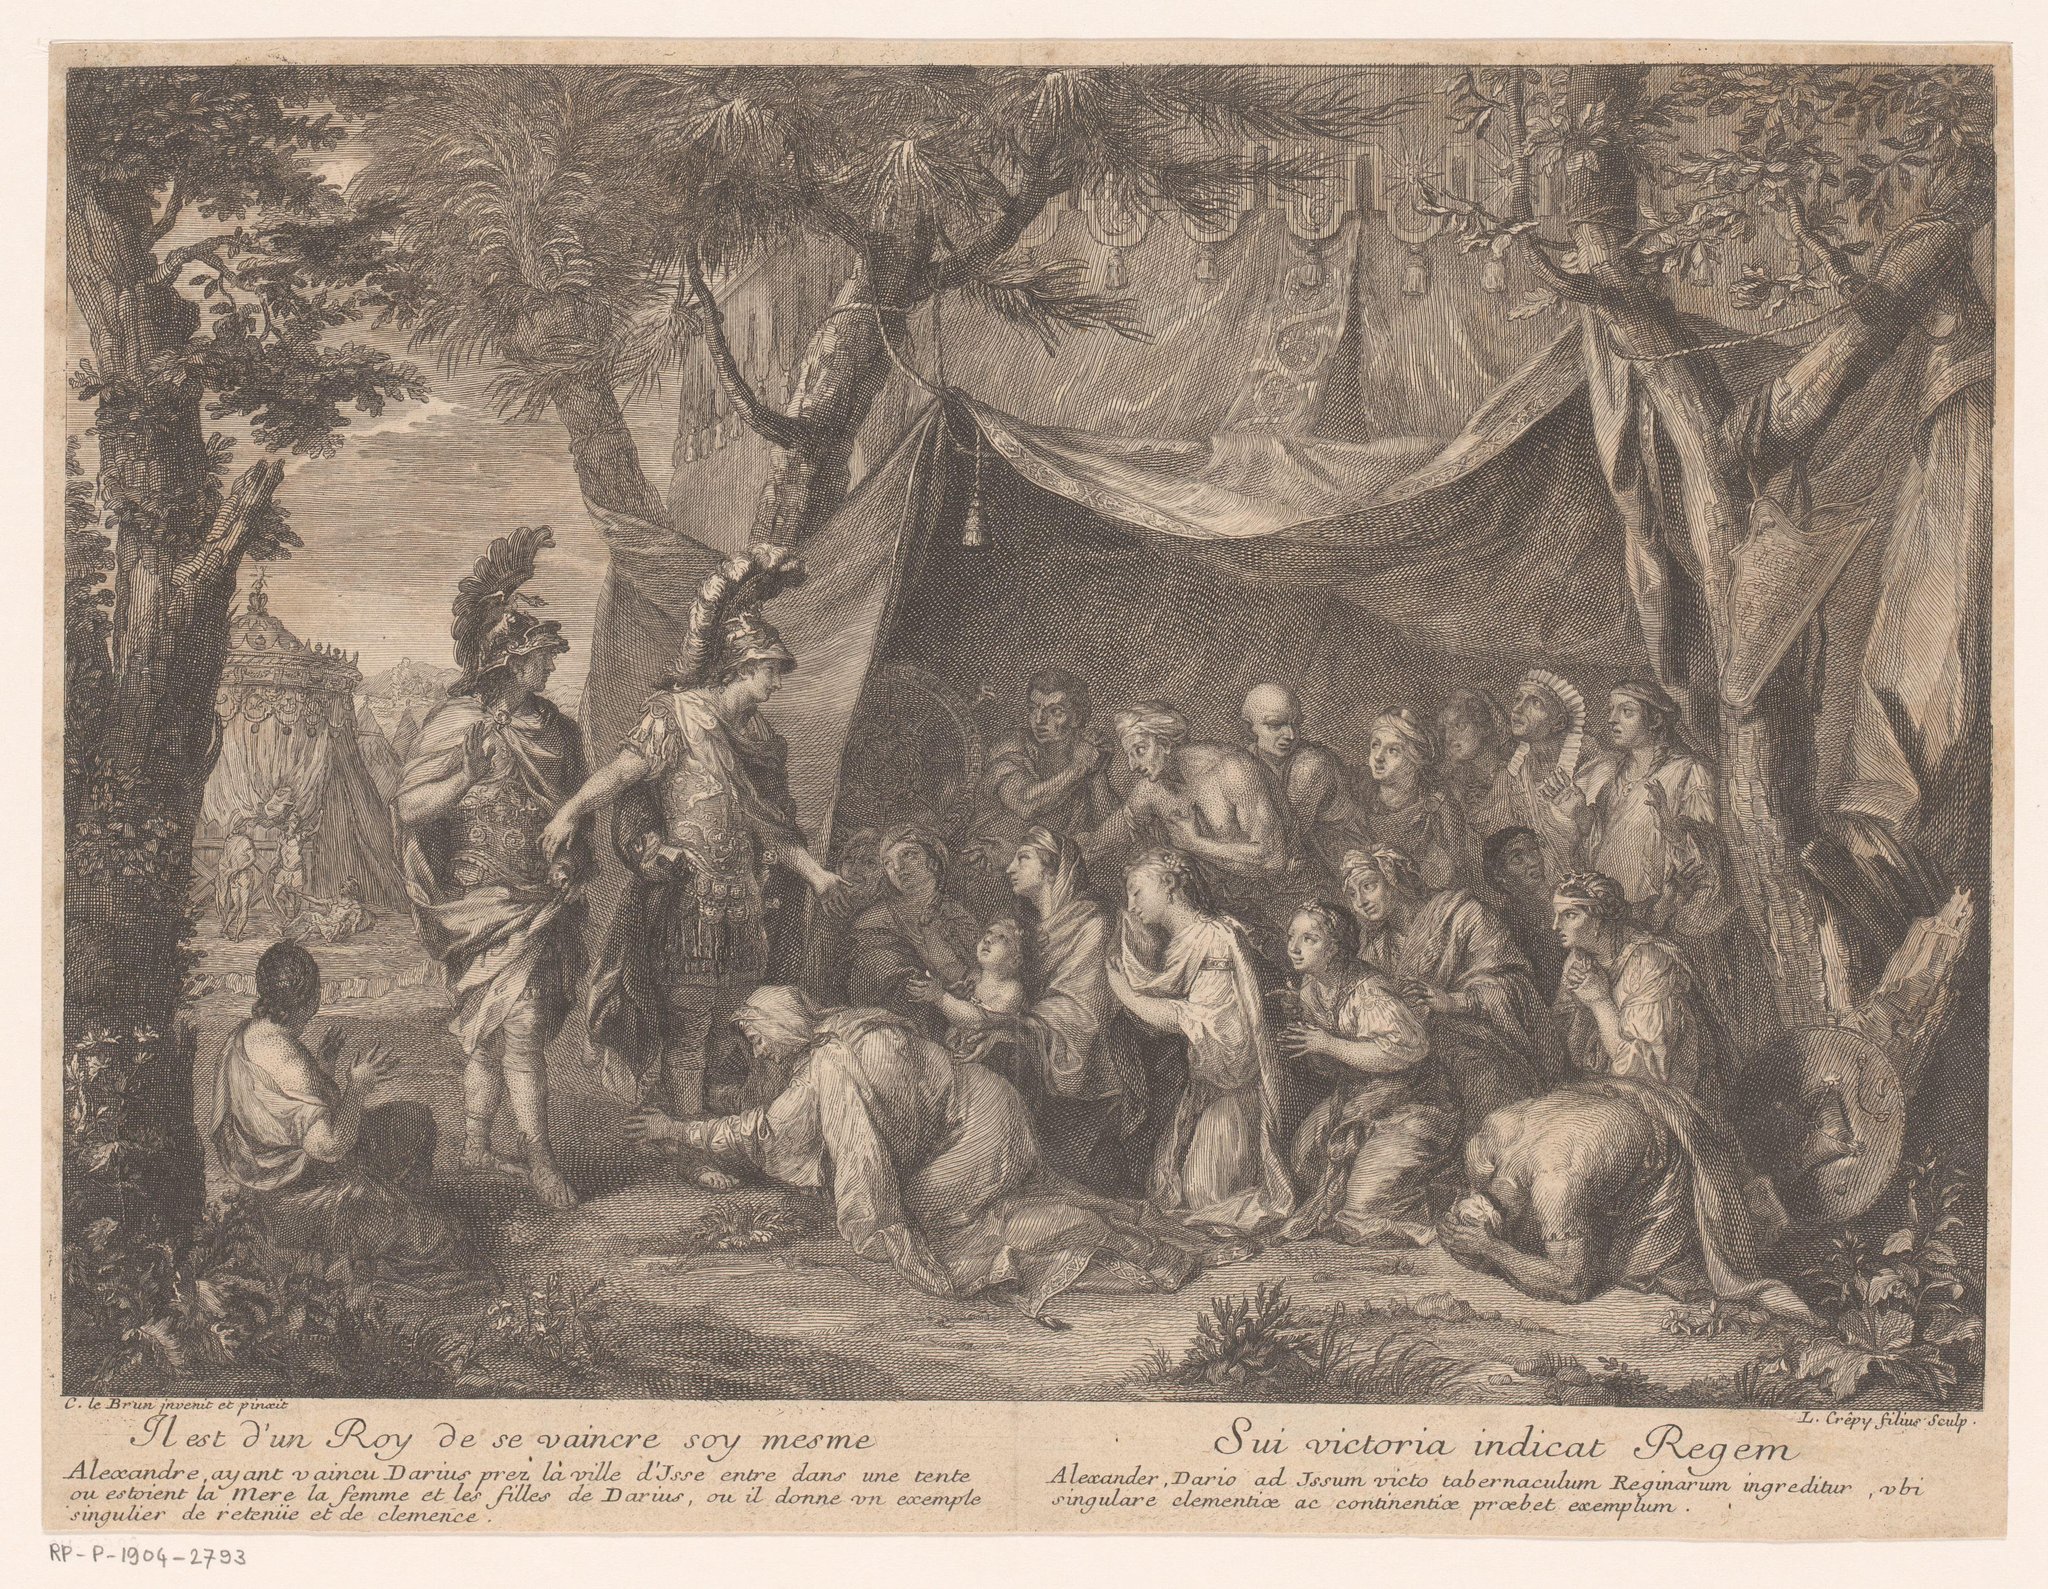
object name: print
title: Alexander de Grote bij de familie van Darius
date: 1690-1754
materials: paper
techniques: engraving, etching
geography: france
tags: historical persons, darius' family kneels before alexander, who requests sisigambis, darius' mother, to rise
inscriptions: collector's mark: Lugt 2228